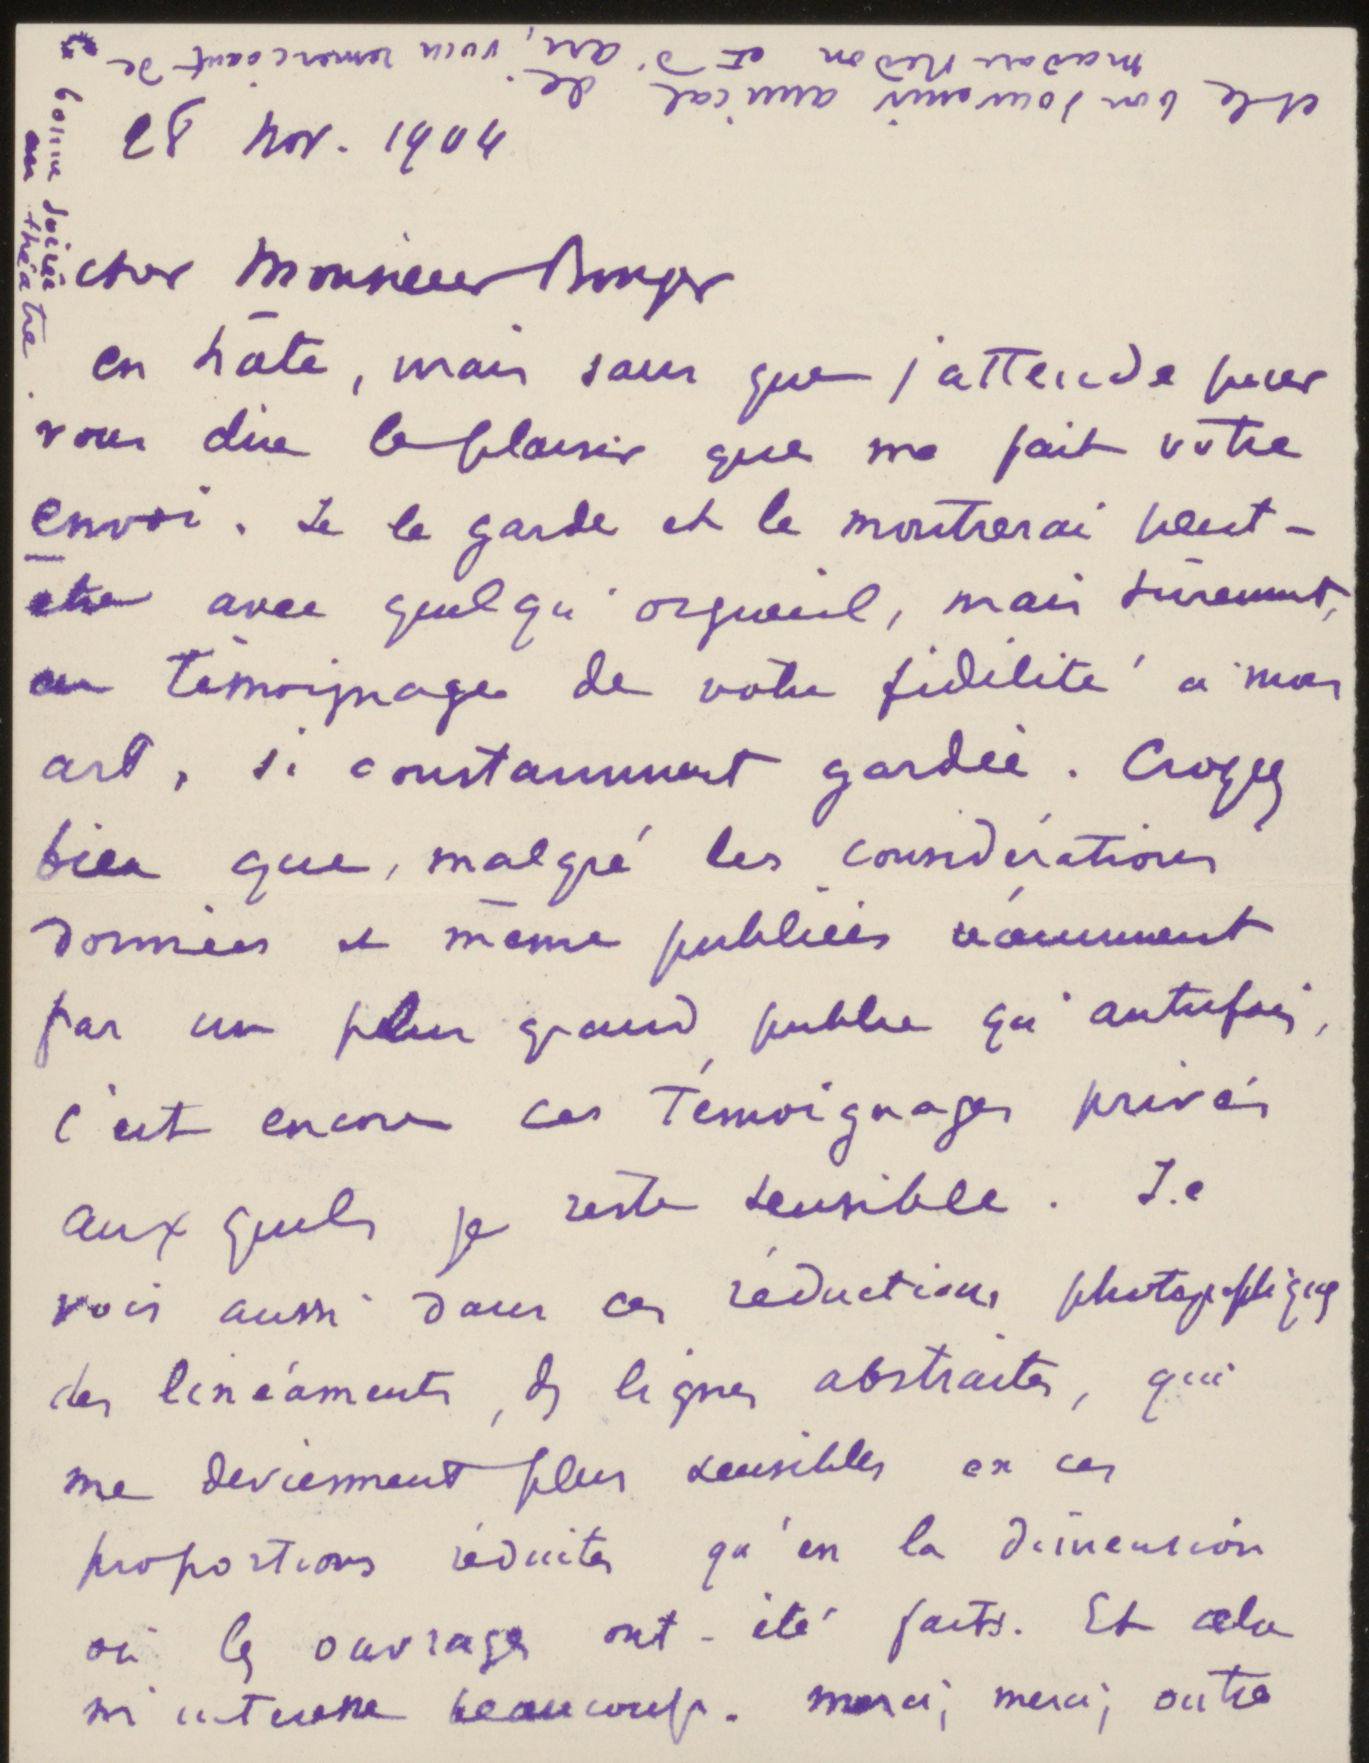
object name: letter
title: Brief aan Andries Bonger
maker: odilon redon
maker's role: draughtsman, painter, print maker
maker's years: 1840-1916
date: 1904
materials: ink, paper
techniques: pen, writing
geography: paris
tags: camille redon-falte, arï redon, amsterdam, andries bonger, drawing, photography, cinematography, the graphic arts, the arts of the stage: ballet, theatre, musical drama, motion picture, printed matter